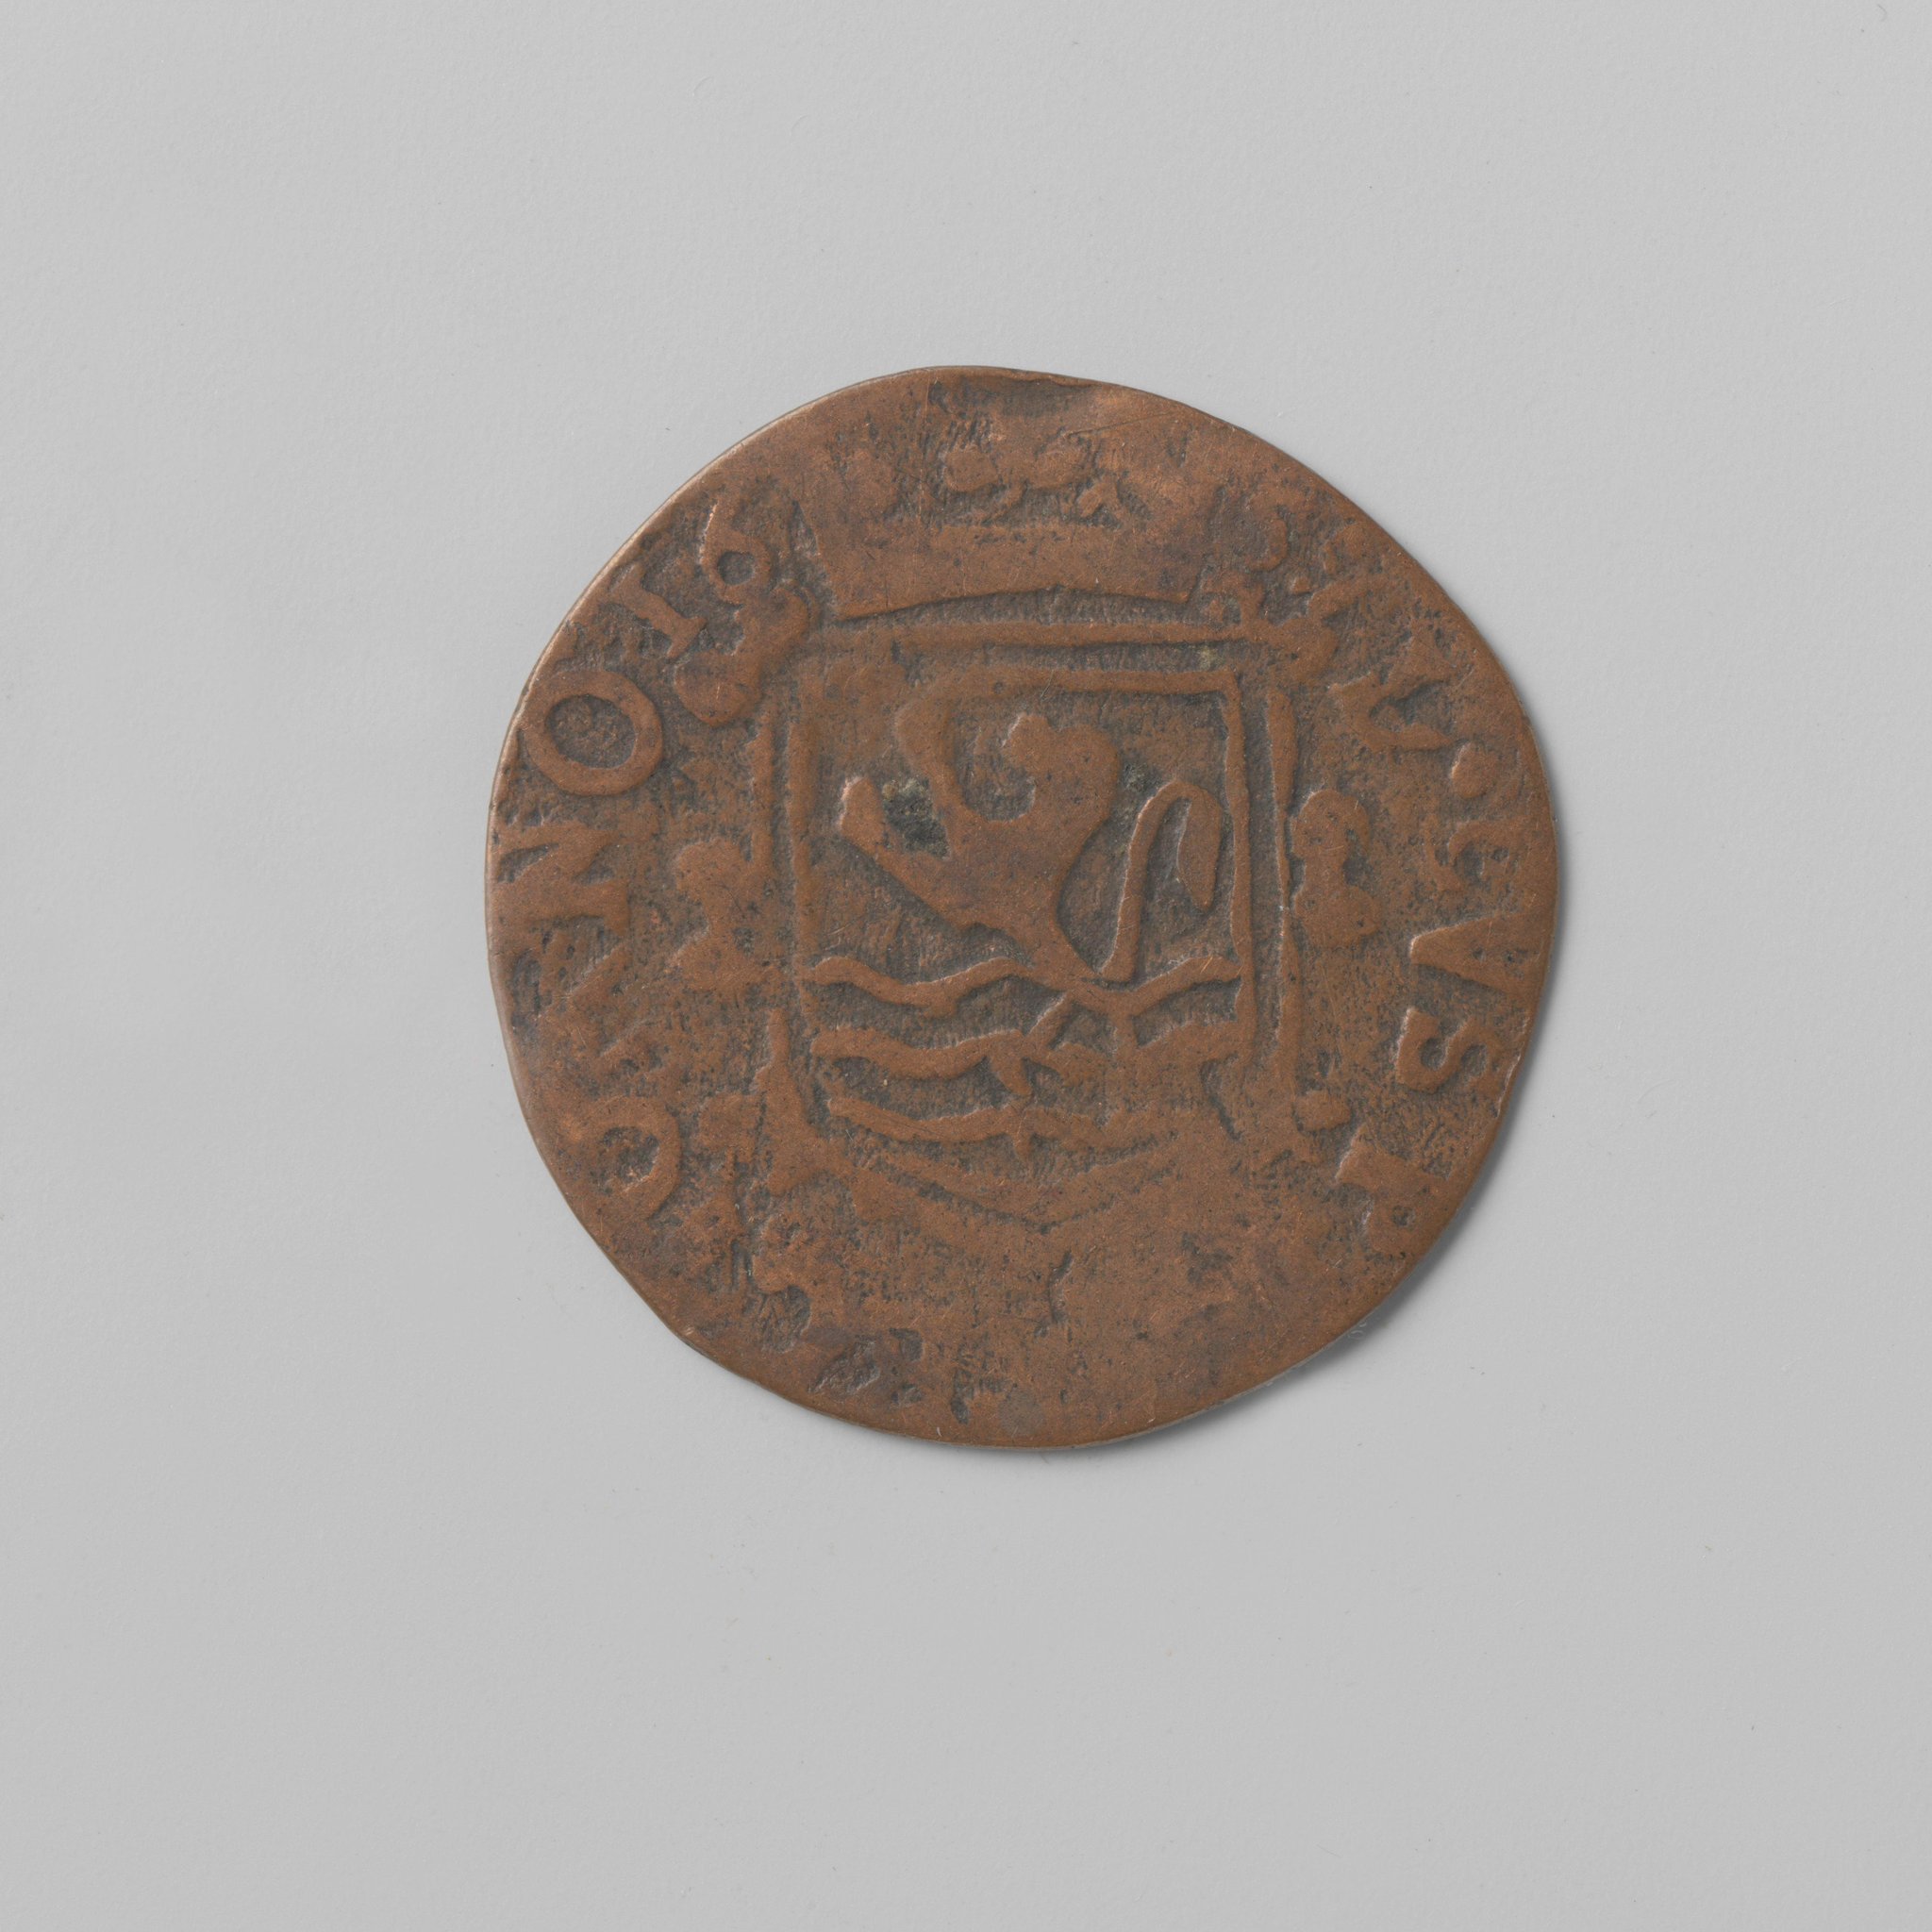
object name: coin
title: Reckheim, Zeeuwse oord, 1659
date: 1659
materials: copper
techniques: striking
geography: rekem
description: Koperen munt. Voorzijde: borstbeeld van prins Maurits naar rechts. Keerzijde: gekroond wapenschild van Zeeland. Jaartal aan weerszijden van kroon. Nabootsing van Zeeuwse oord.